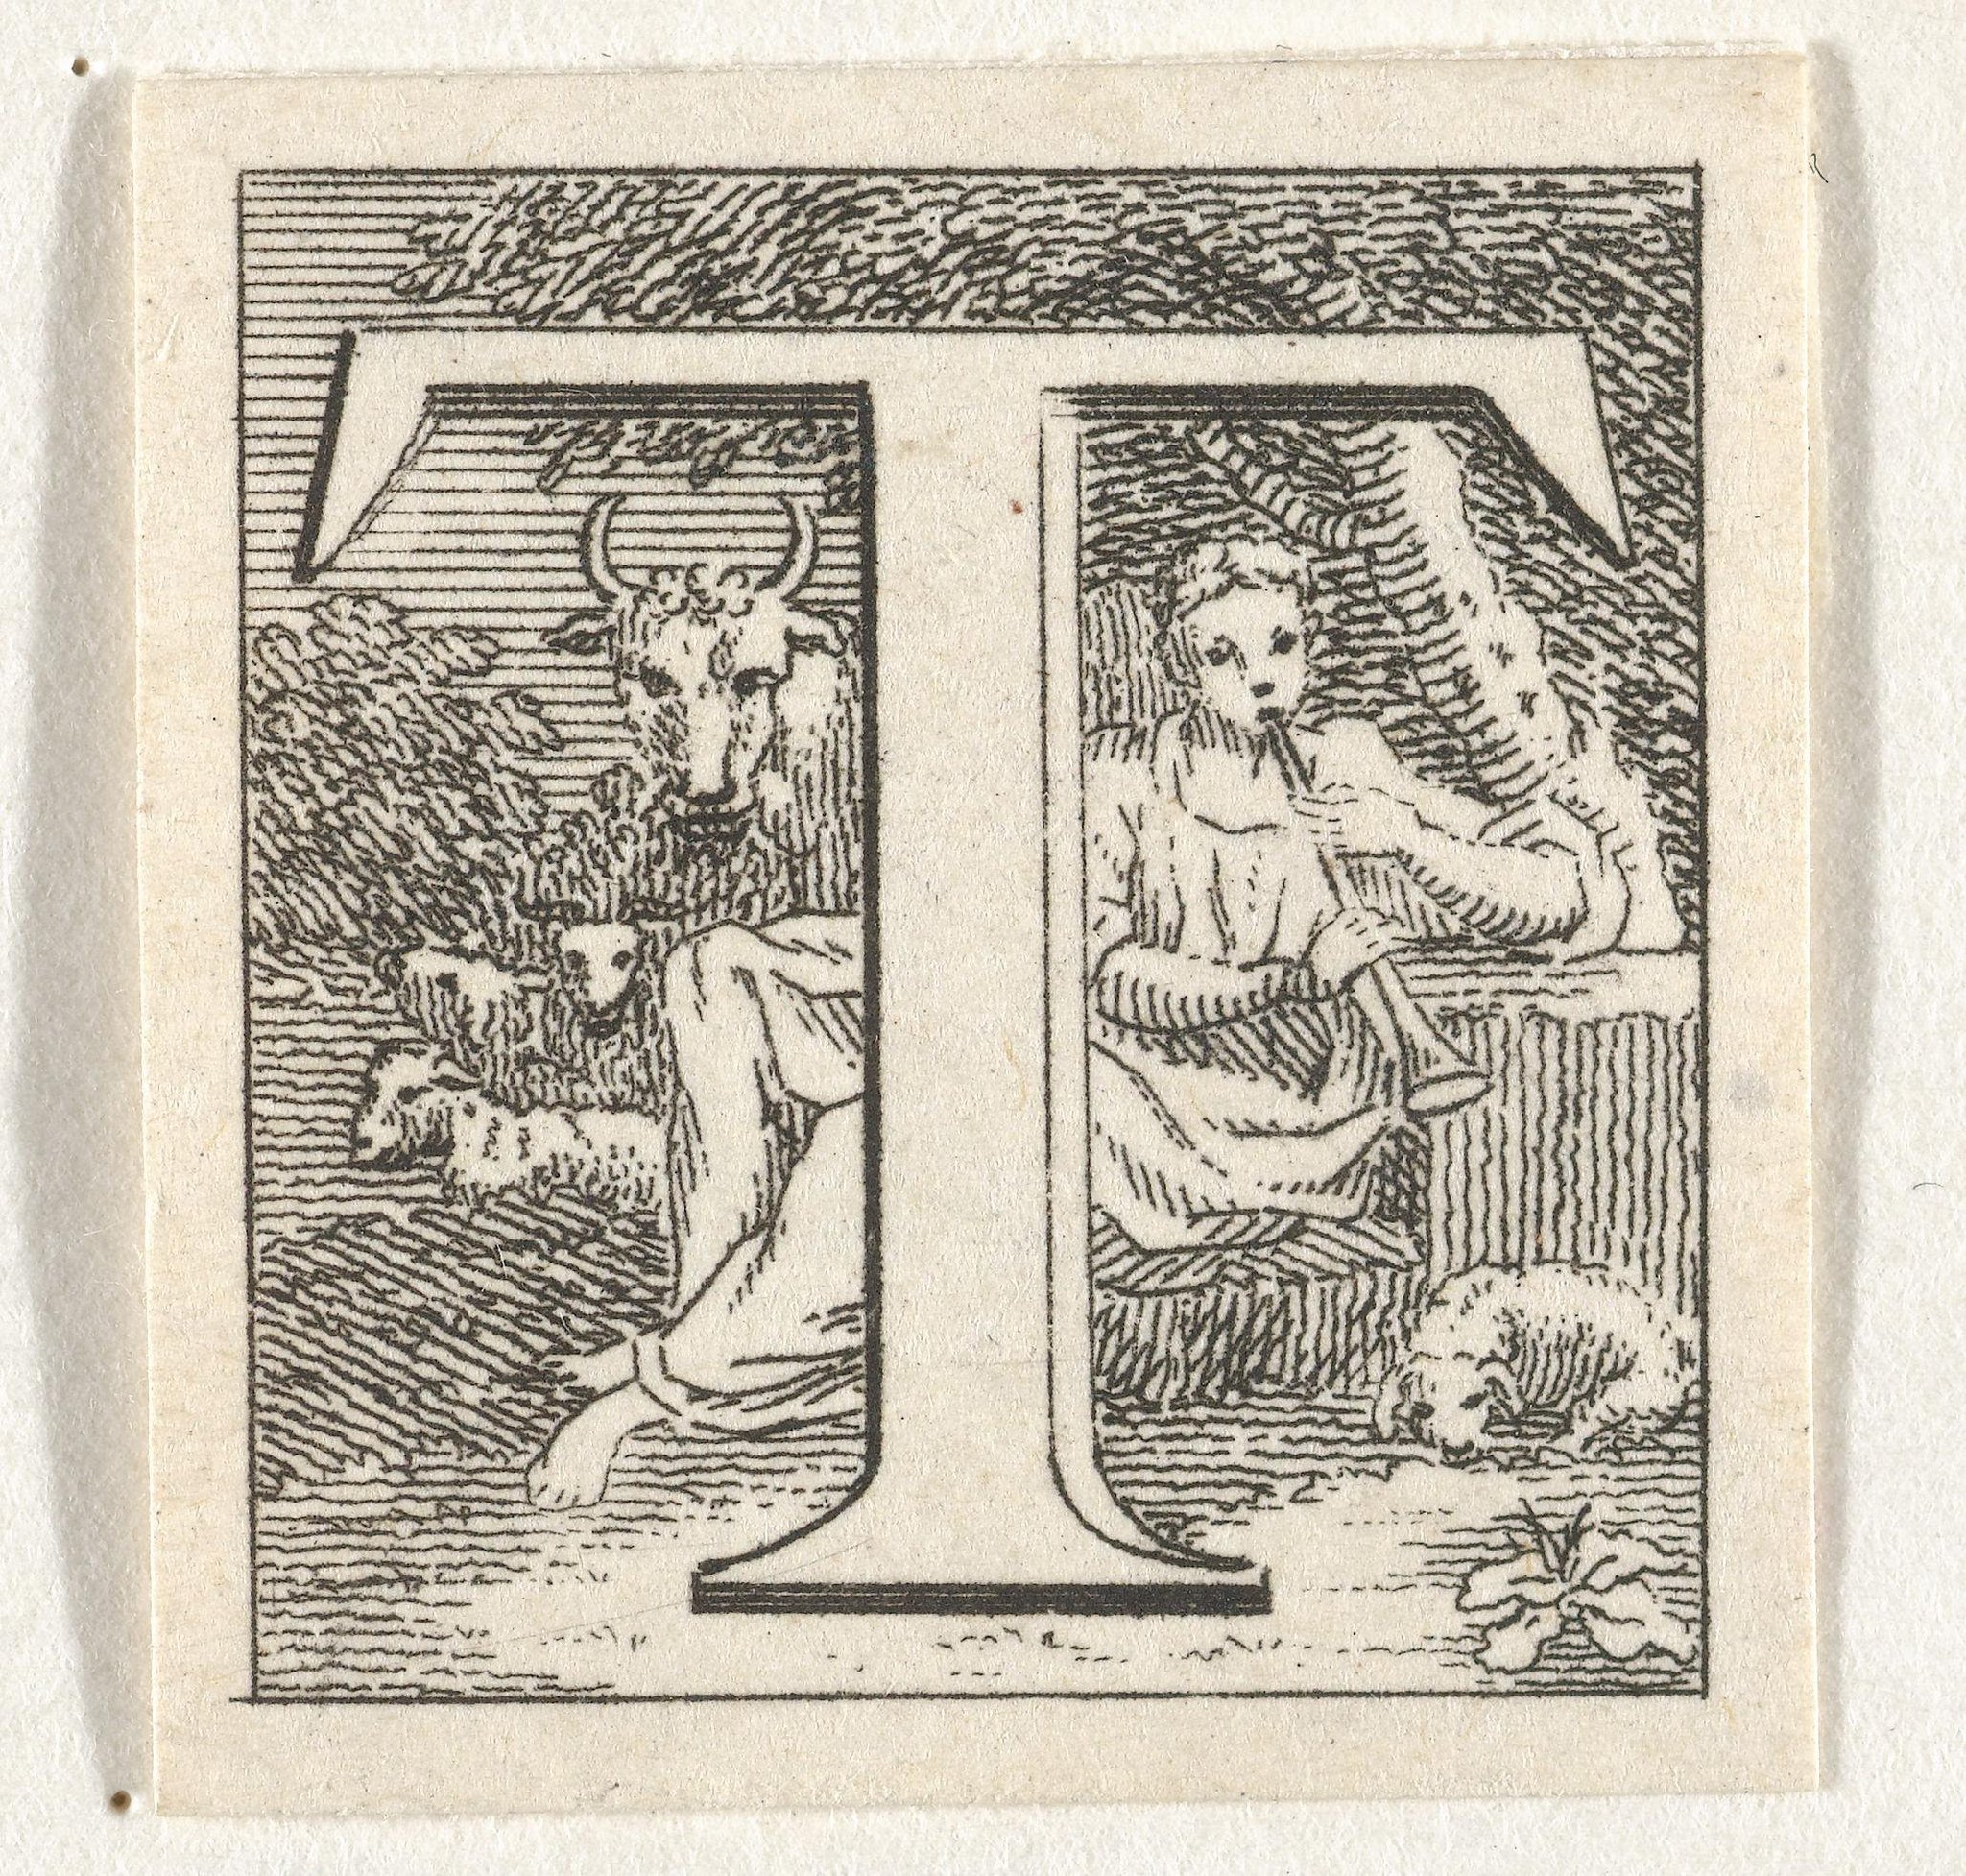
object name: print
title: Hoofdletter T met beeltenis van een herder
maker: jacob folkema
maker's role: draughtsman, print maker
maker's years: 1692-1767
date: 1702-1767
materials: paper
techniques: etching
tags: herding, herdsman, herdswoman, shepherd, shepherdess, cowherd, etc., initial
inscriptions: collector's mark: Lugt 240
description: Hoofdletter T met de beeltenis van een fluit spelende herder, omringd door enkele dieren.